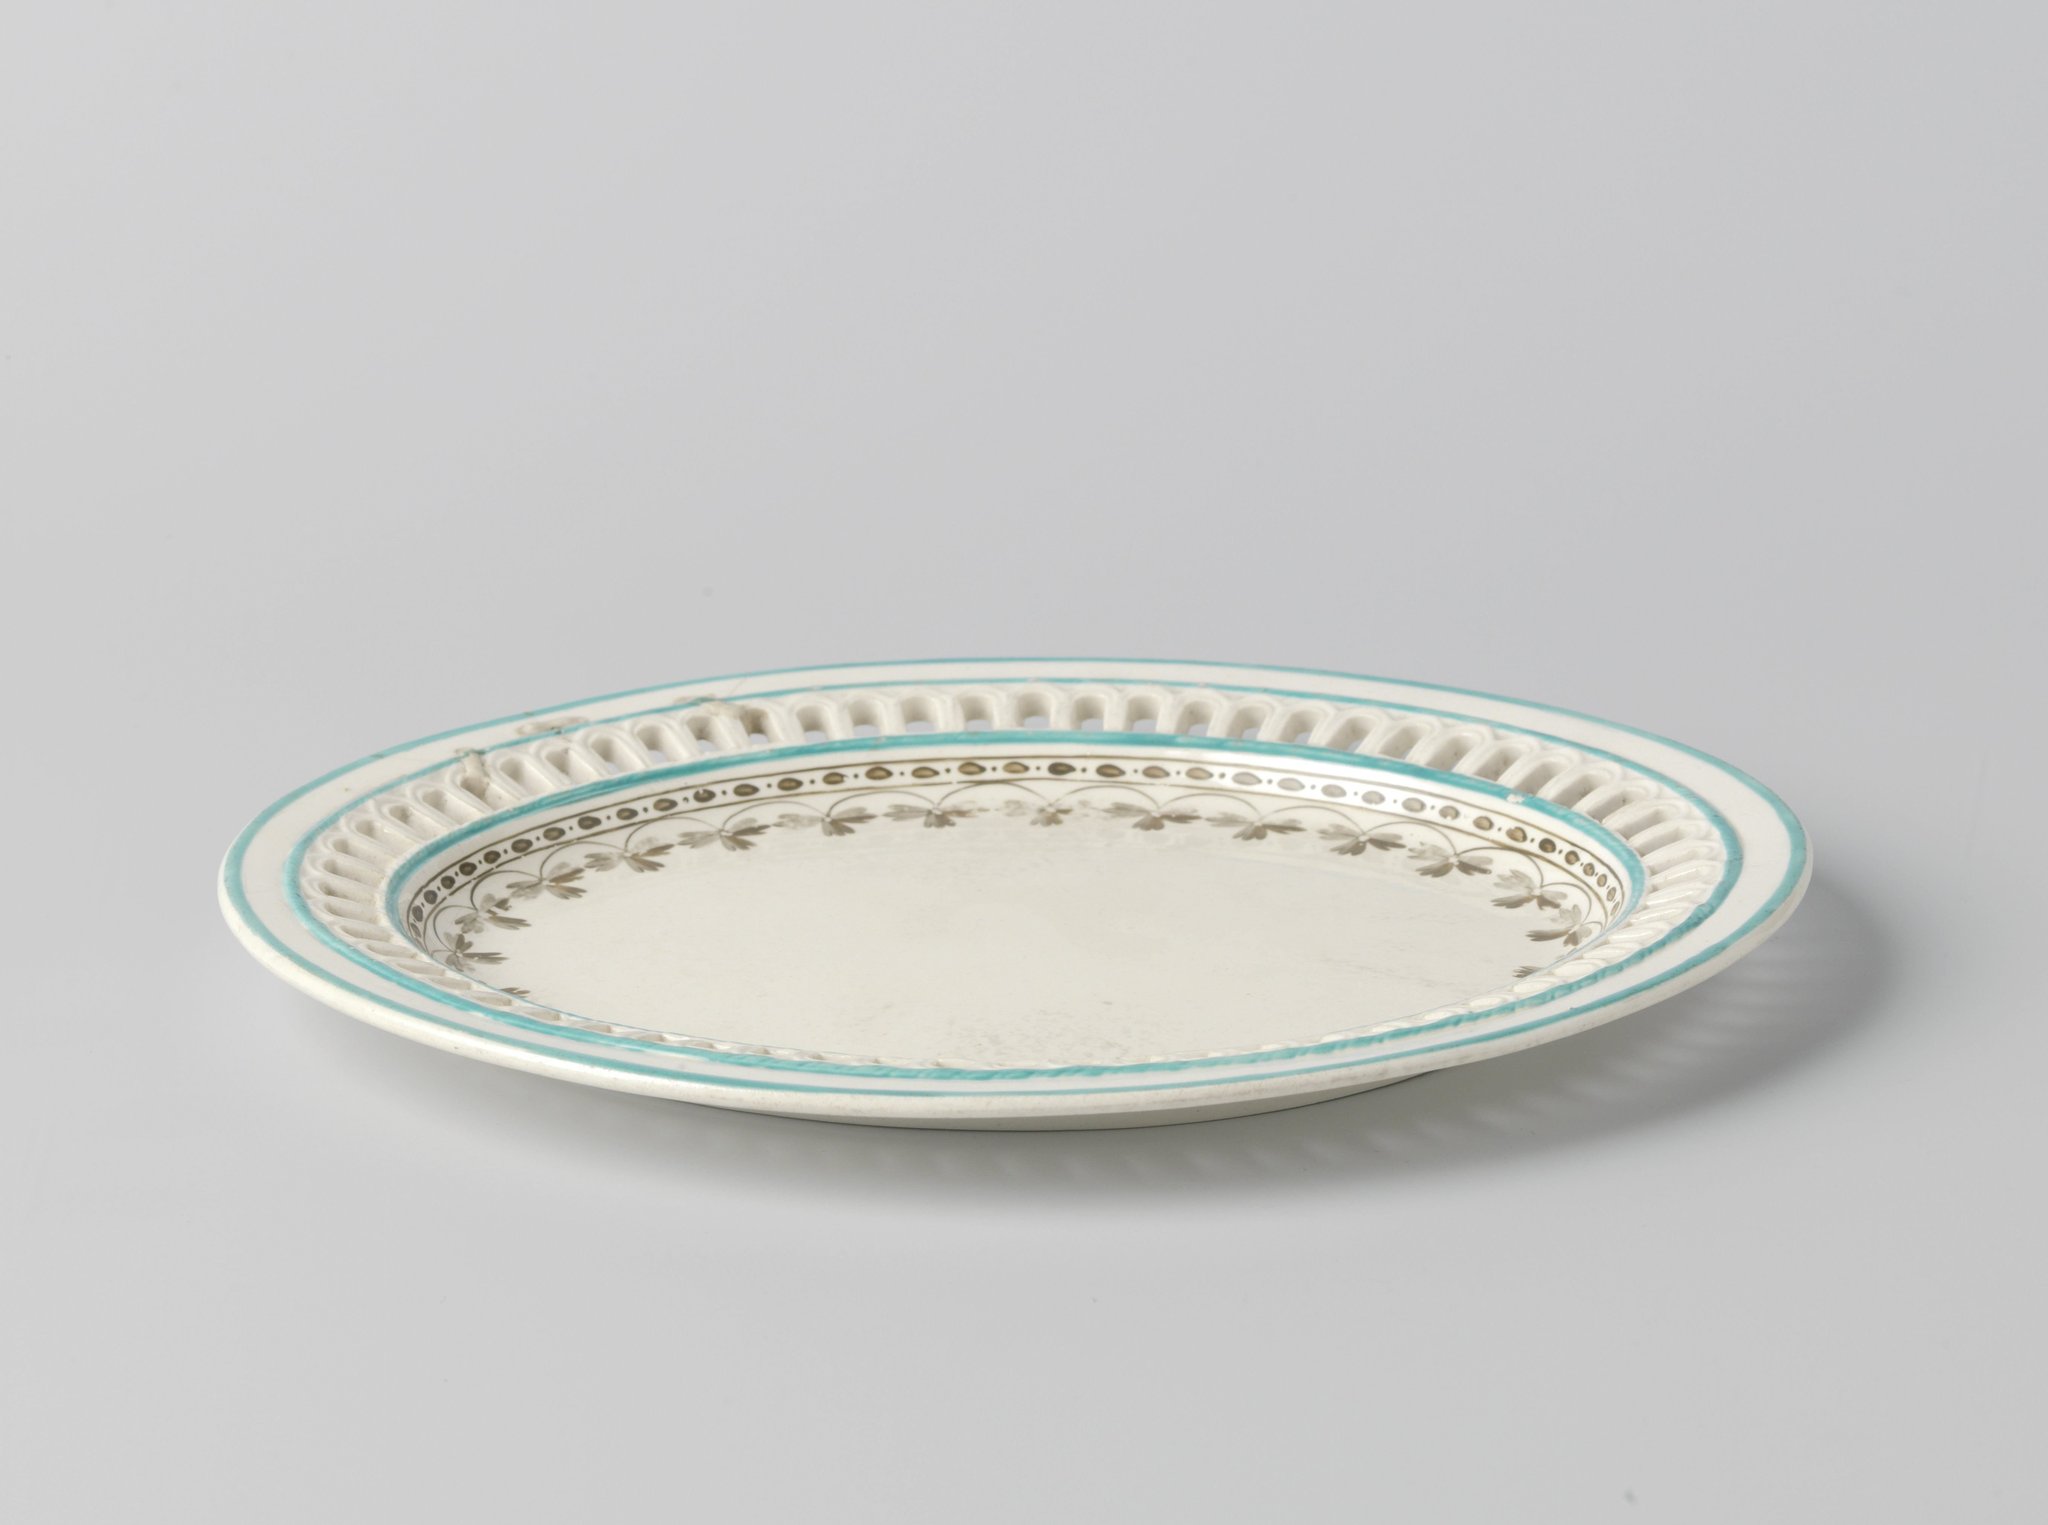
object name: platter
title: Ovale schotel van hardgebakken aardewerk, Spode ware, creamware.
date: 1790-1820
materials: earthenware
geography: stoke-on-trent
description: Ovale schotel van hardgebakken aardewerk, met een opengewerkte rand. De schotel hoort bij een fruitmand. De opengewerkte rand is met licht groen geëmailleerde reliëfbanden versierd. Daarbinnen loopt een bruin geschilderde bladrand. De schotel is gemerkt met een blindstempel: Spode.